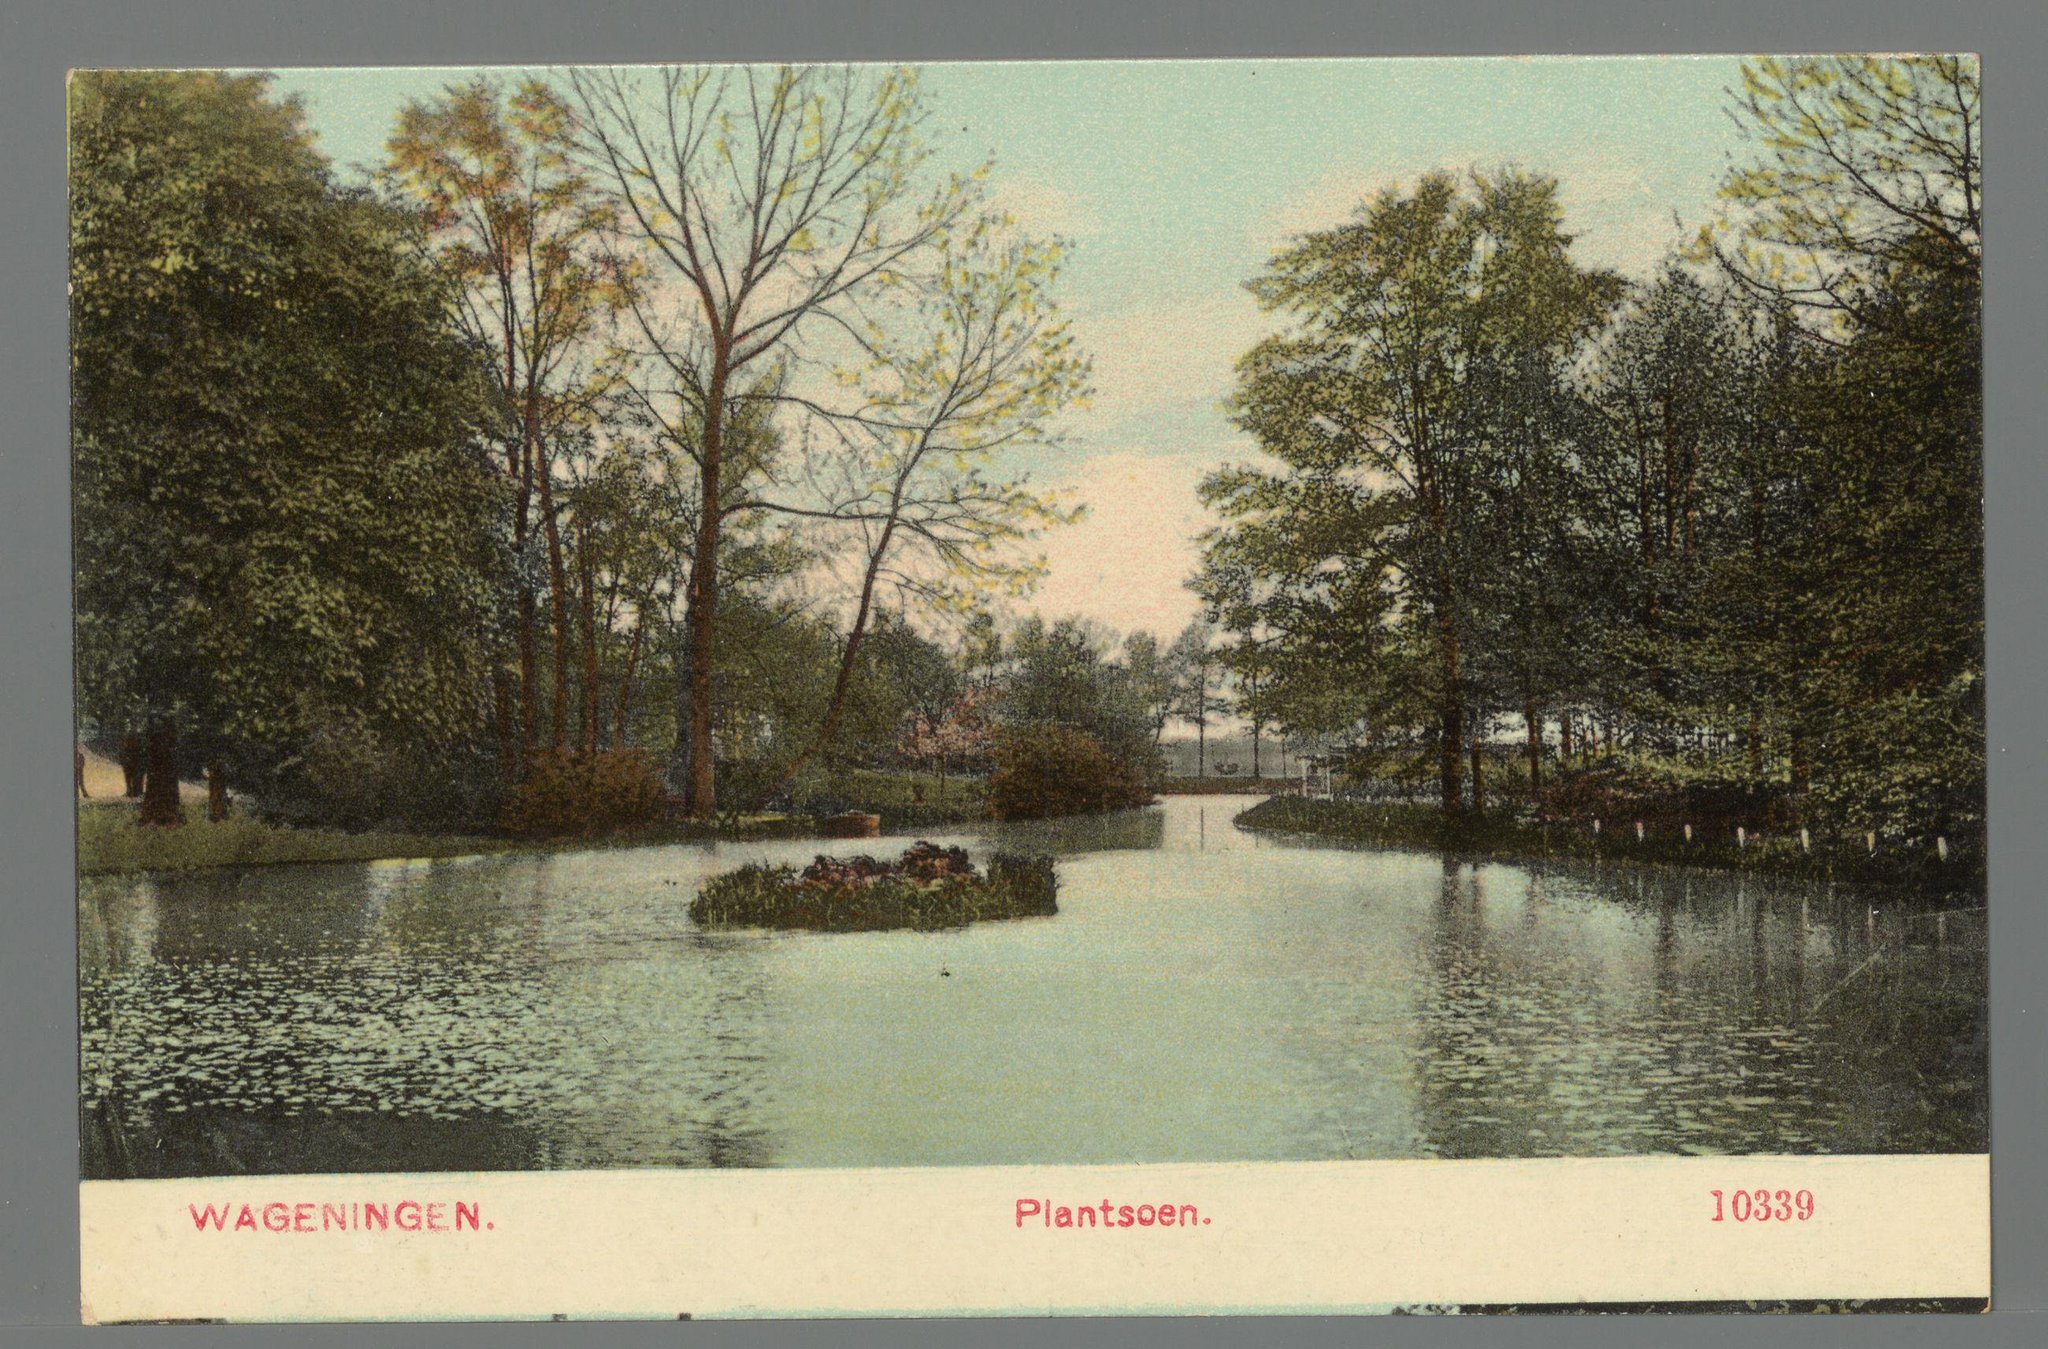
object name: ansichtkaart, prentbriefkaart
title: Wageningen. Plantsoen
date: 1905-1927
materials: cardboard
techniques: photograph, lithograph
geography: velsen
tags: park, pond